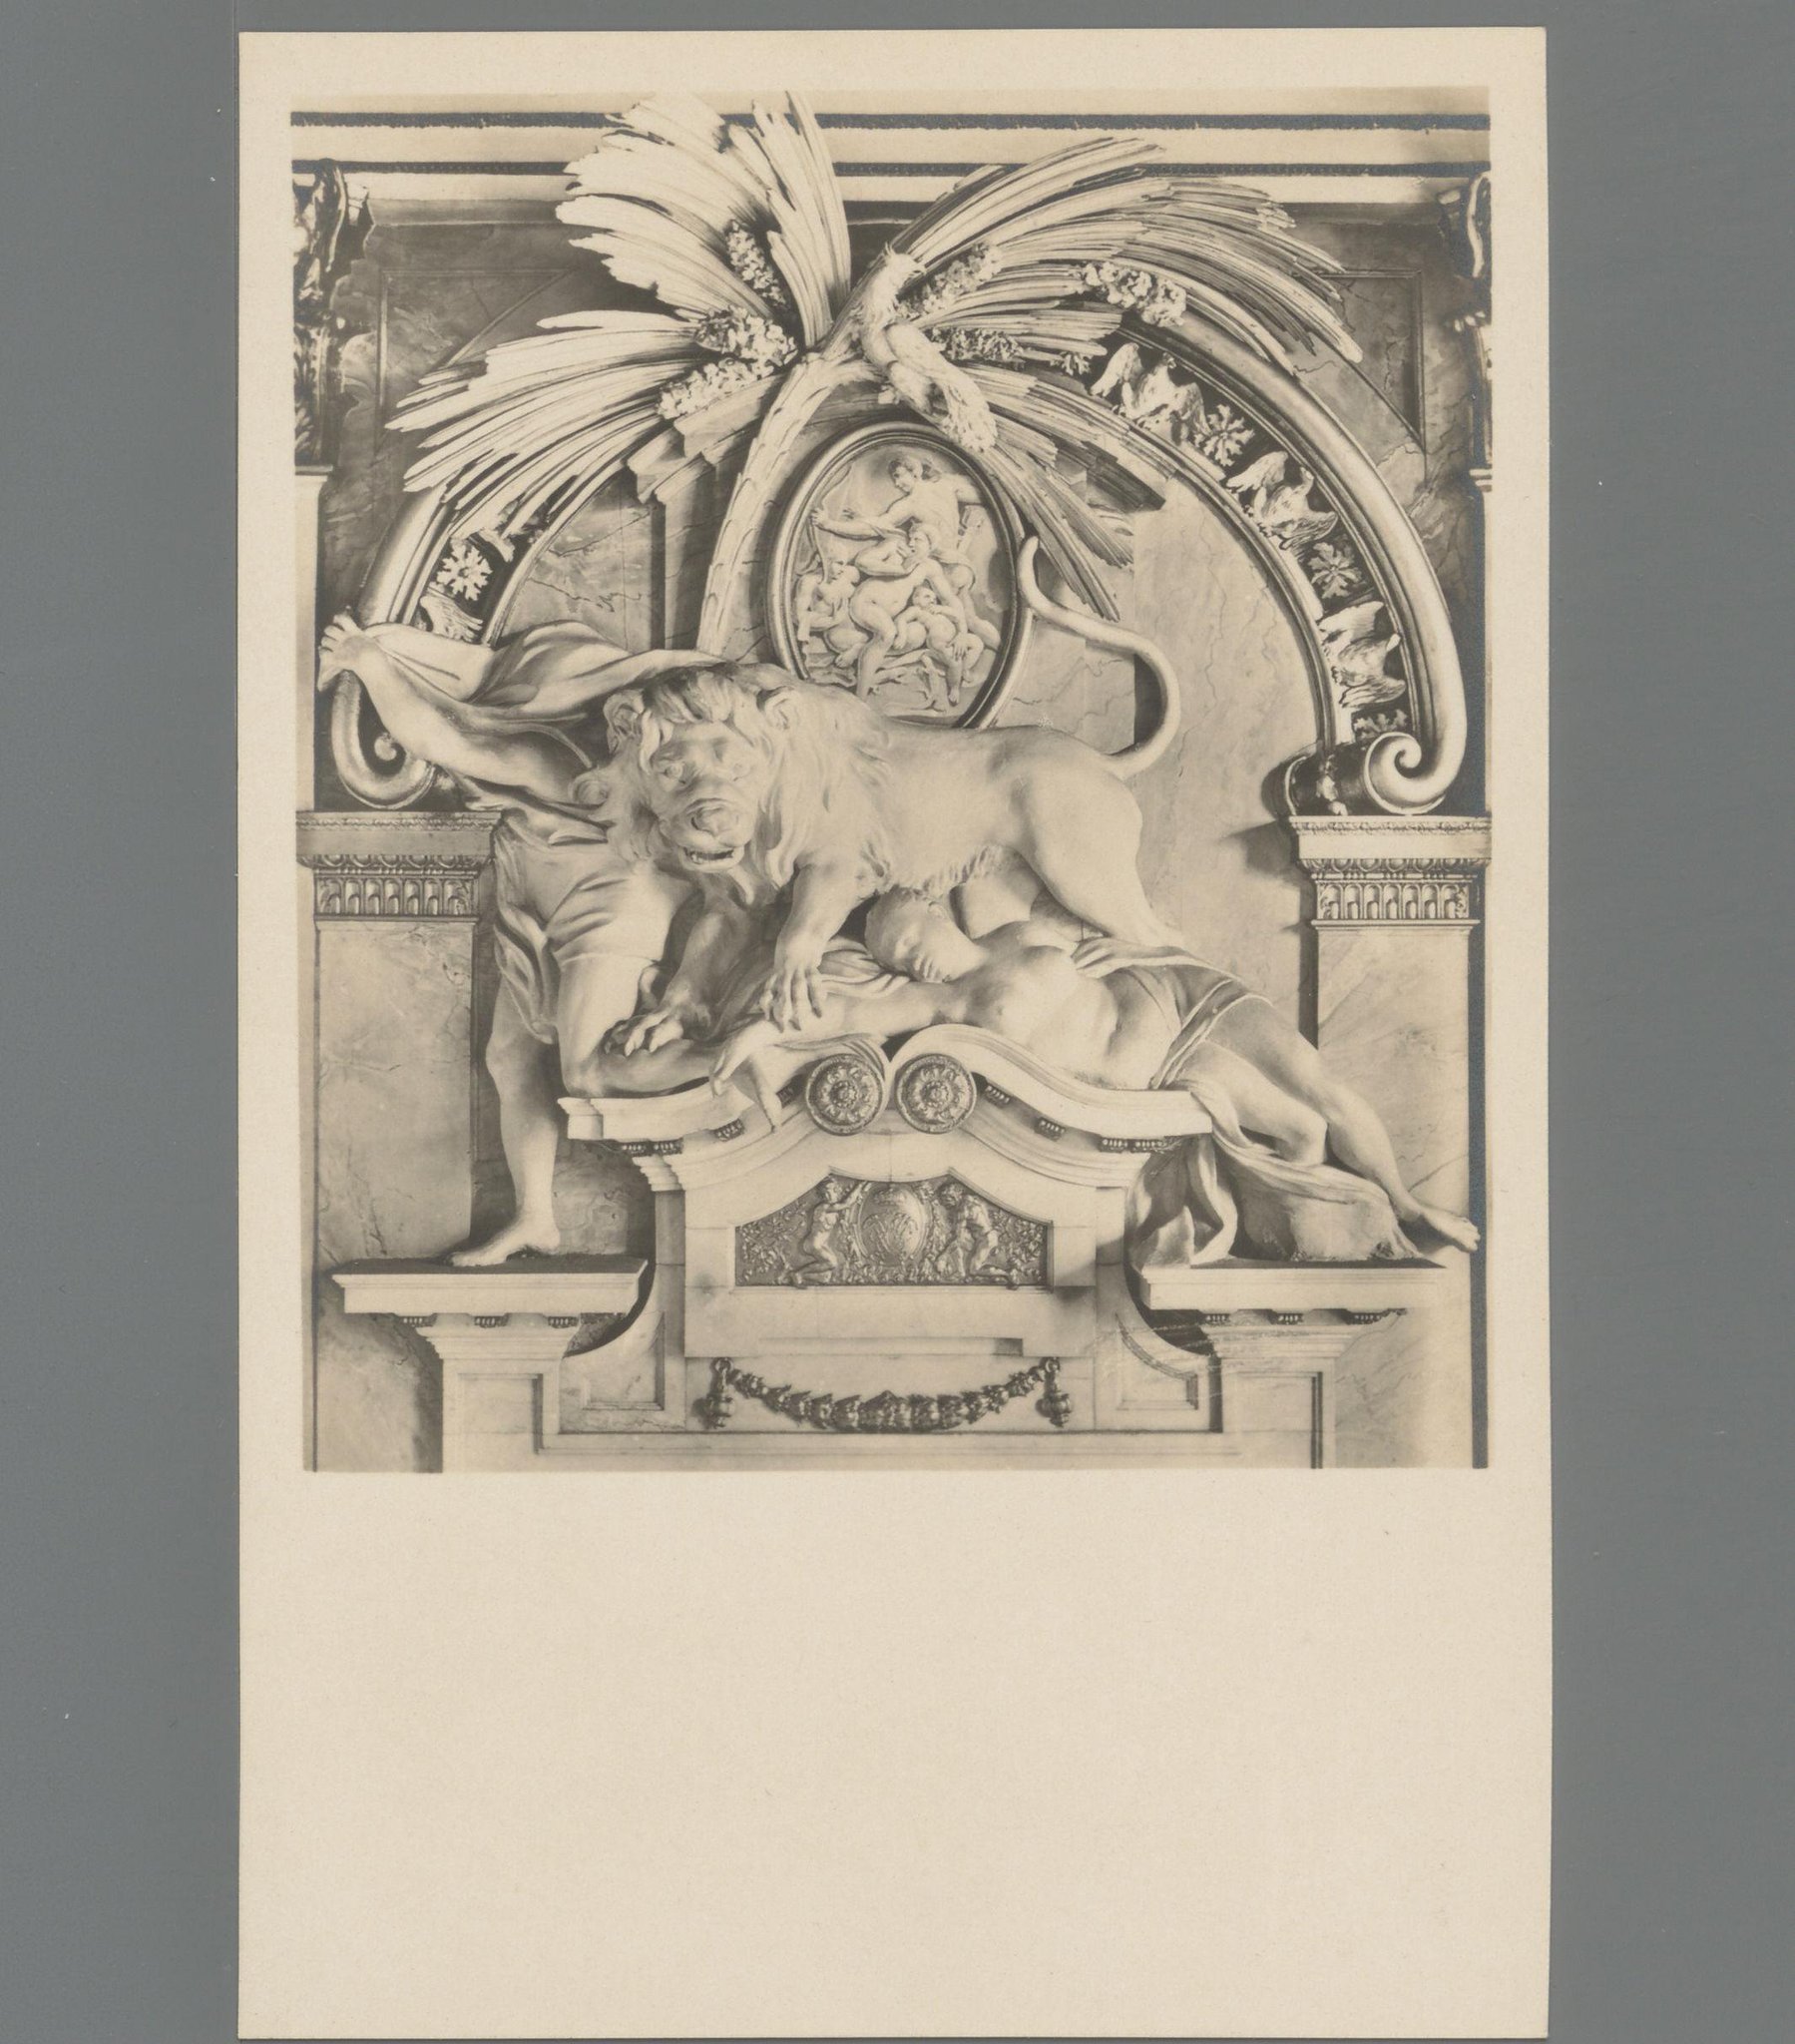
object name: photograph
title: Berlin, Schloss. Paradekammern, Rittersaal. Andreas Schlüter: "Afrika"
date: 1900-1930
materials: photographic support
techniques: photography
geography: berlin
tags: africa represented allegorically; 'africa' (ripa), castle, interior of the house